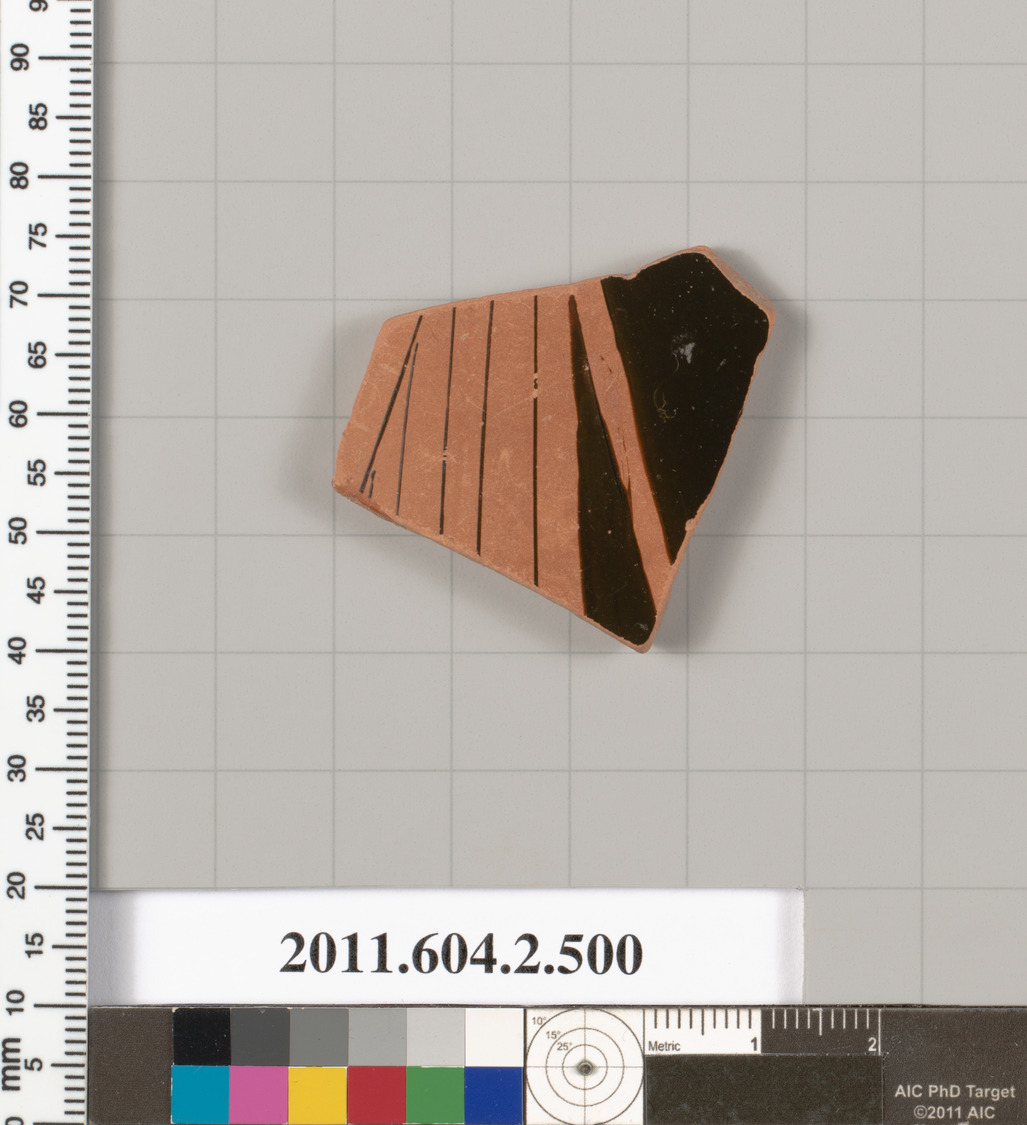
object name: column krater fragment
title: Terracotta fragment of a column-krater (bowl for mixing wine and water)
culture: greek, attic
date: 460-440 BCE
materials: terracotta